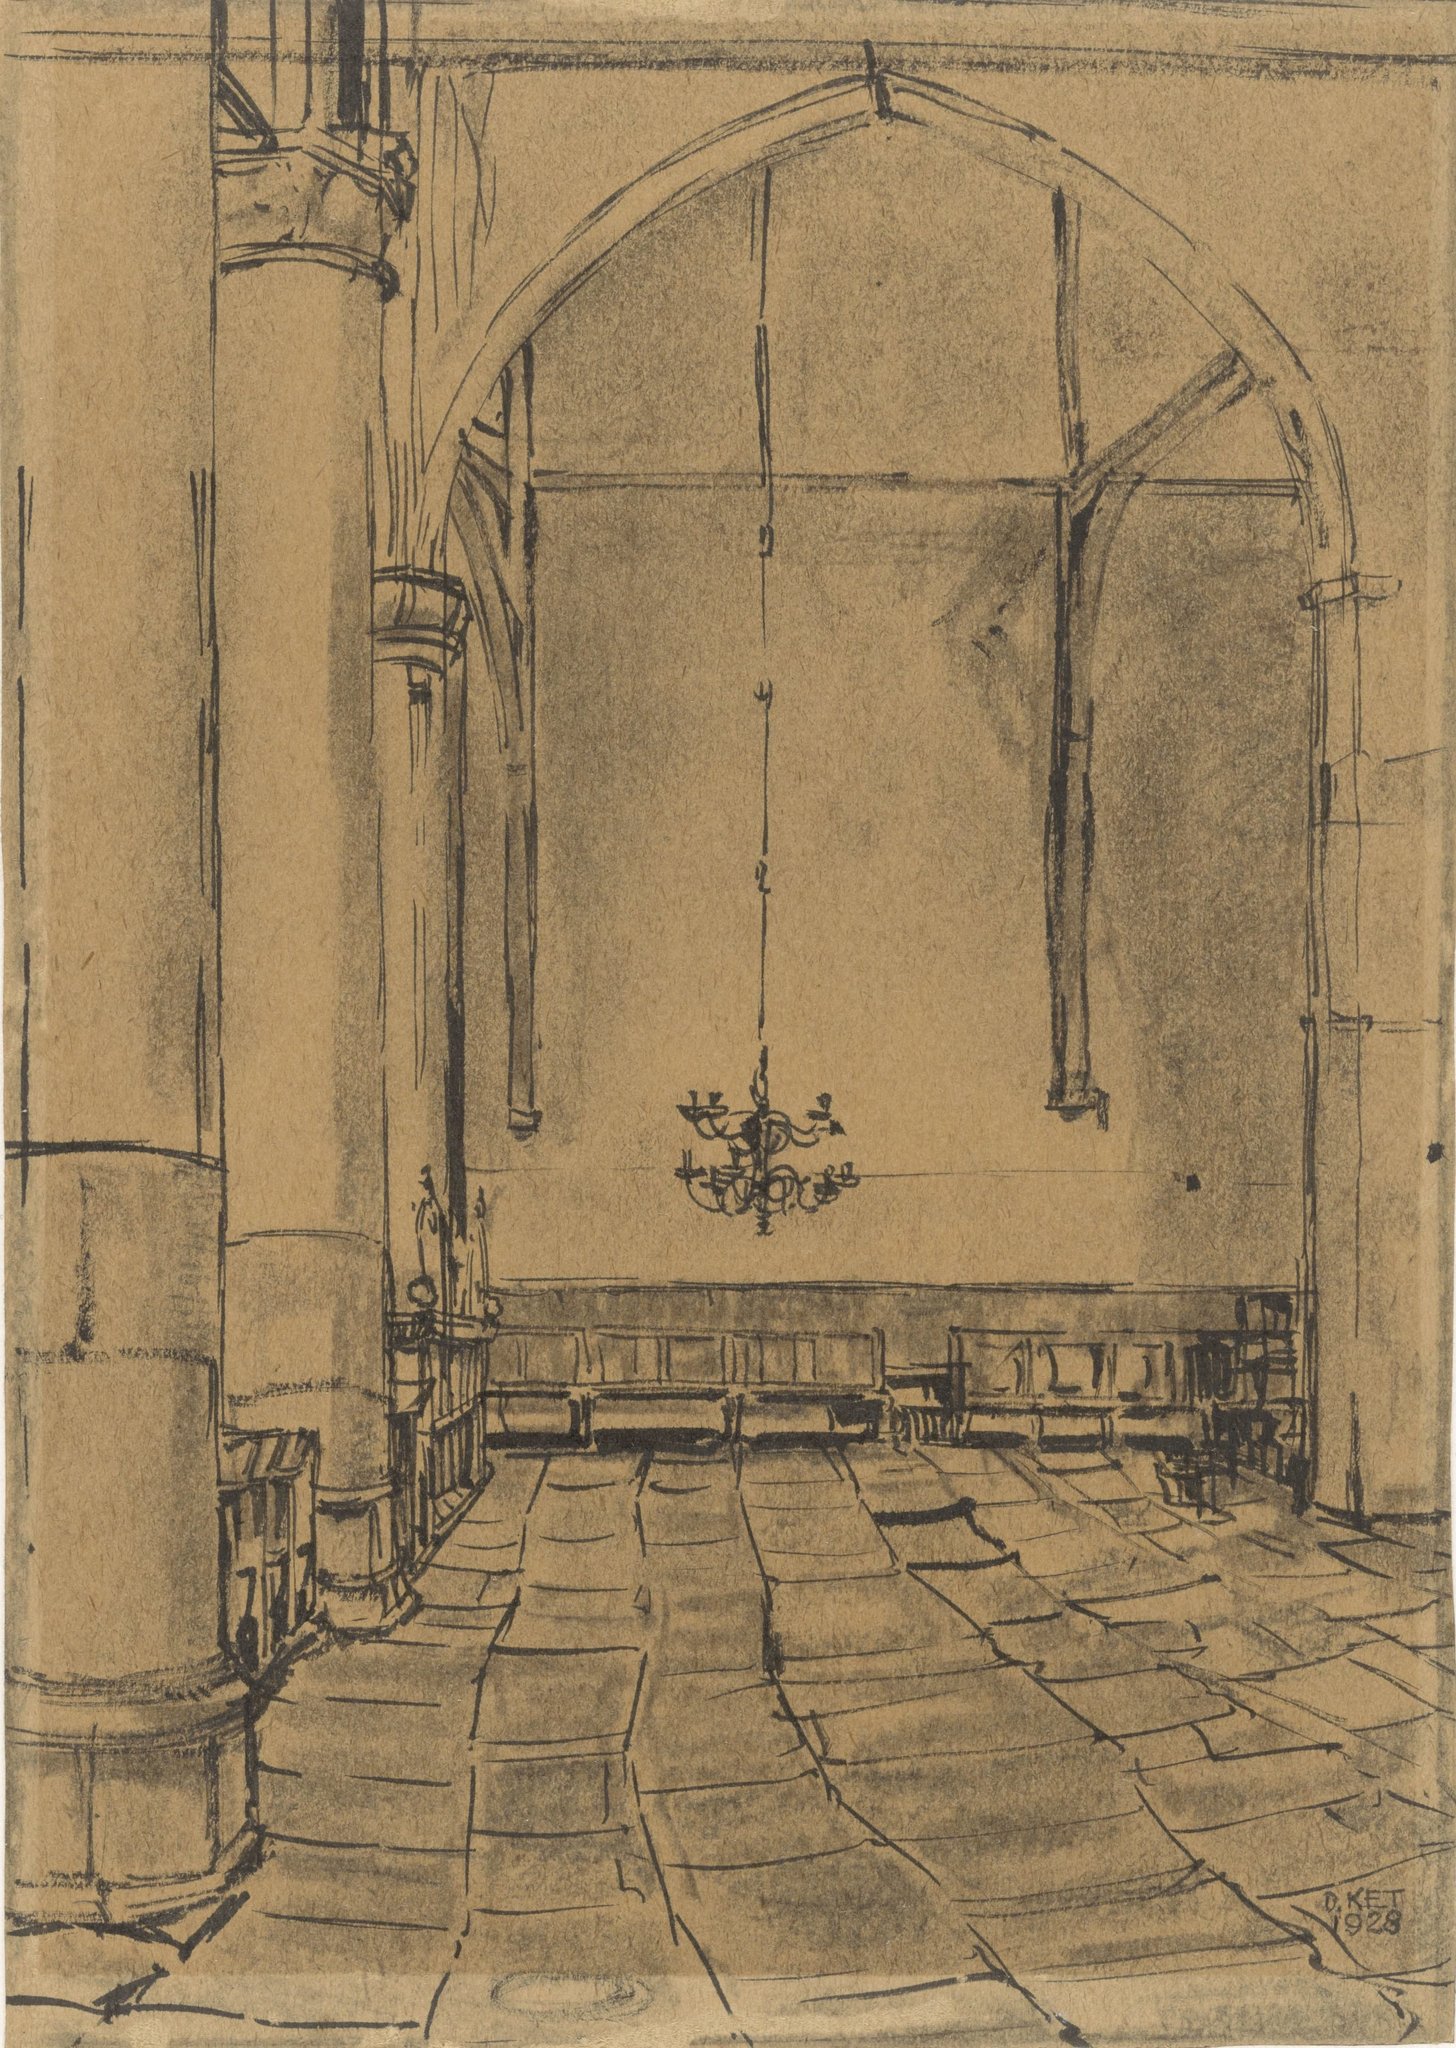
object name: drawing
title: Interieur van de kerk in Hoorn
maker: dick ket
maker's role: draughtsman, print maker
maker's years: 1902-1940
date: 1928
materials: charcoal, ink, paper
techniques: pen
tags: parts of church interior, hoorn (north holland)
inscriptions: label, collector's mark: Lugt 2228, stamp: ‘Galerie FERMA[TE]/ jan en eja fokkens/ [...]weg 29/ epe tel. 4053’